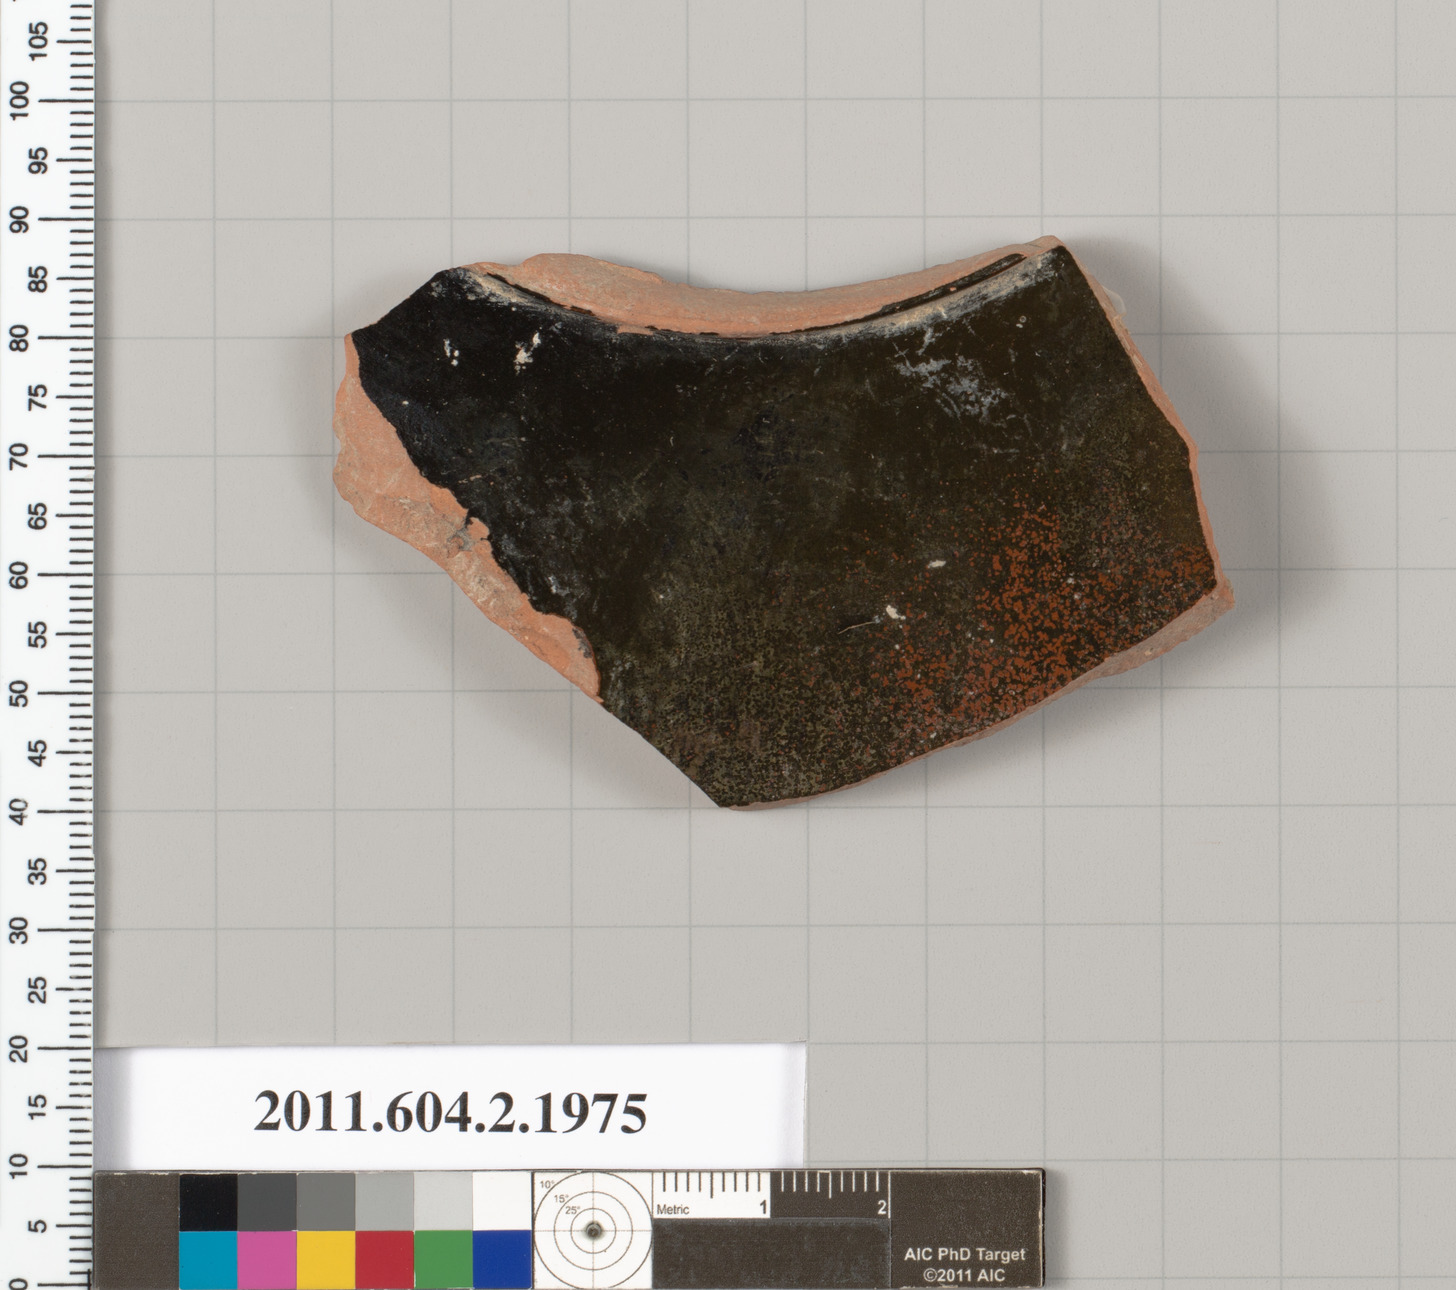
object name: kalpis fragment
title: Terracotta fragment of a hydria: kalpis (water jar)?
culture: greek, attic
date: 475-451 BCE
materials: terracotta